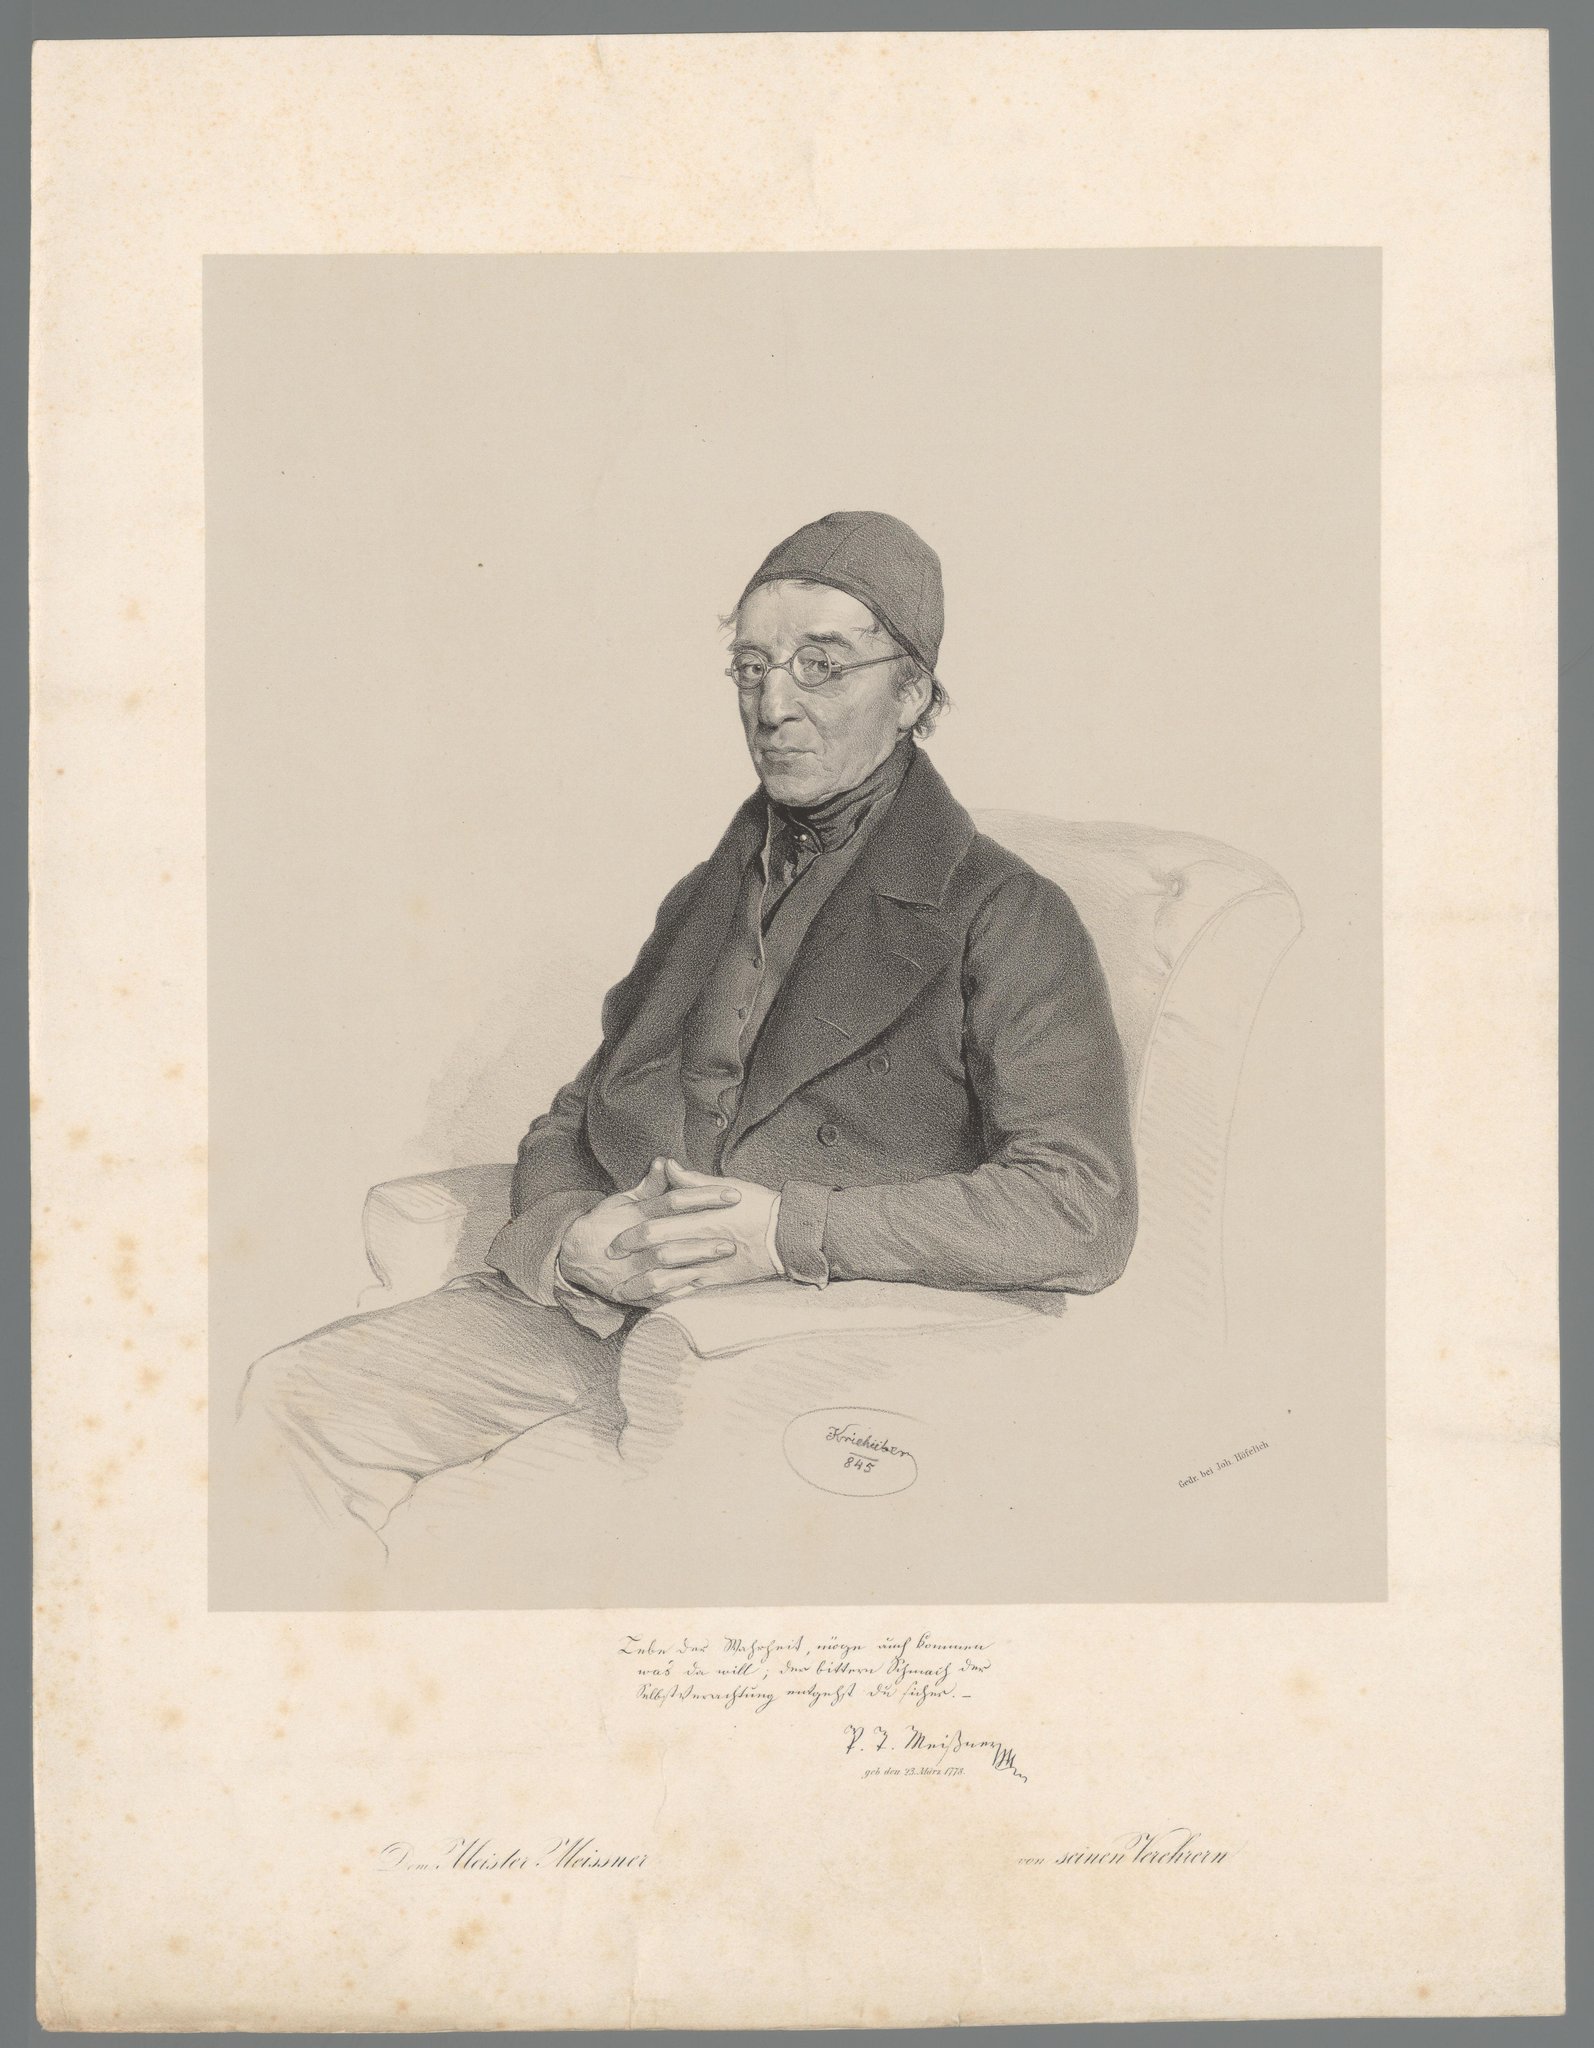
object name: print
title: Portret van Paul Traugott Meissner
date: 1845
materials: paper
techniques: lithograph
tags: vienna, chemistry, historical persons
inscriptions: collector's mark: Lugt 2228